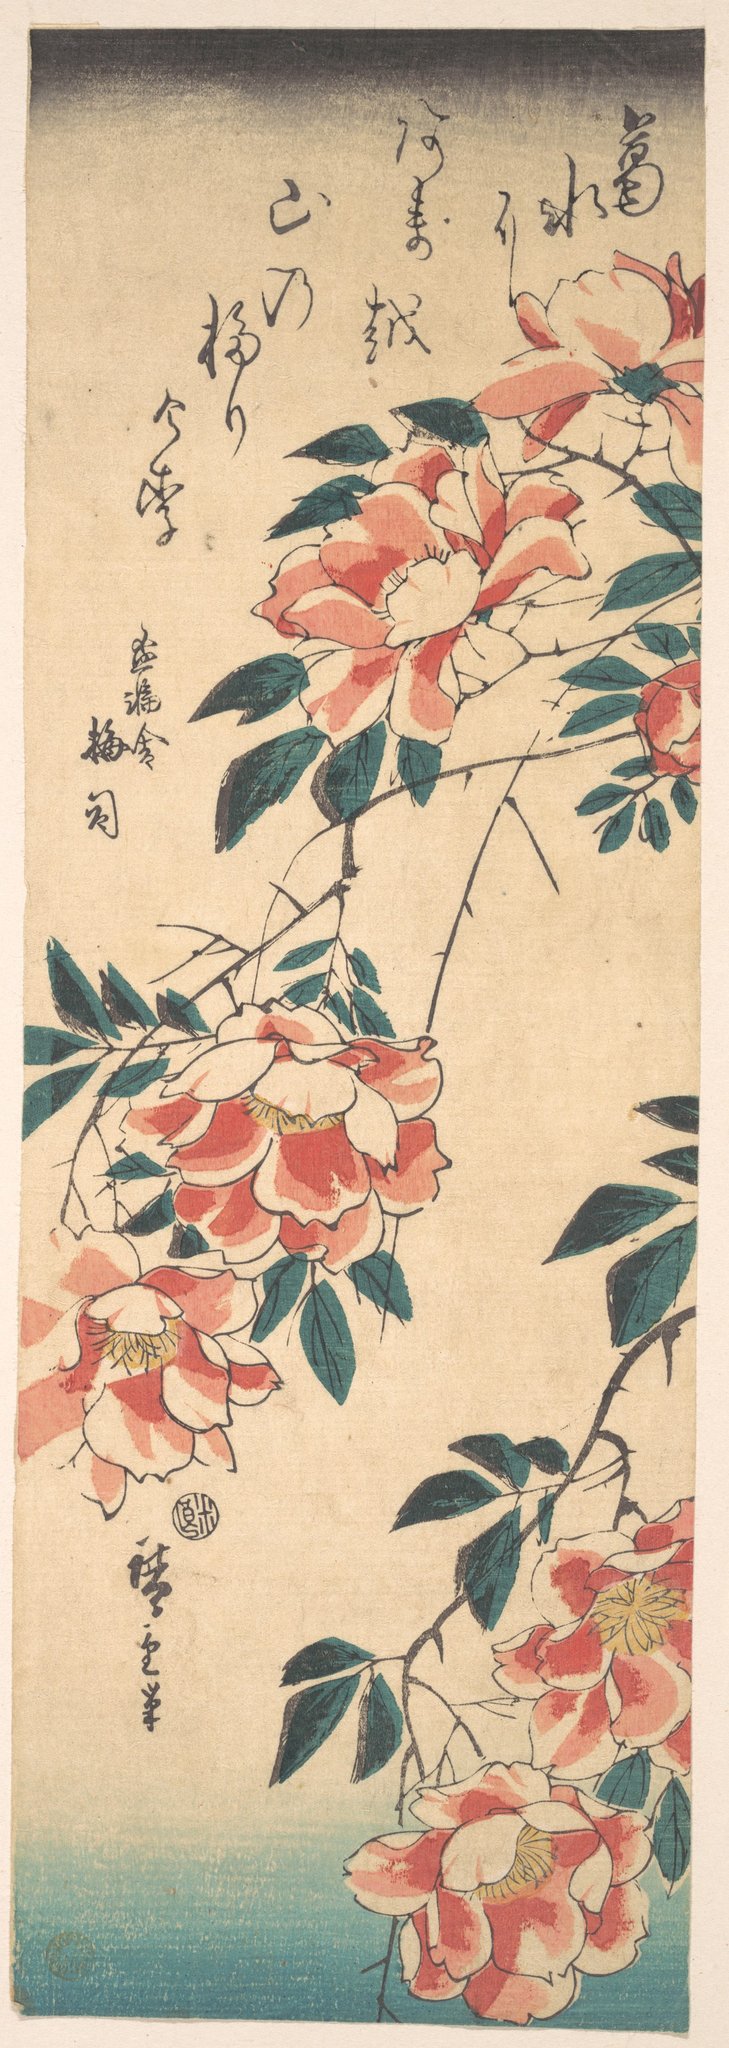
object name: print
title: Roses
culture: japanese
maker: utagawa hiroshige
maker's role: artist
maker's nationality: japanese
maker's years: 1797-1858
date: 1843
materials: ink, paper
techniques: woodblock print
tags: roses,leaves